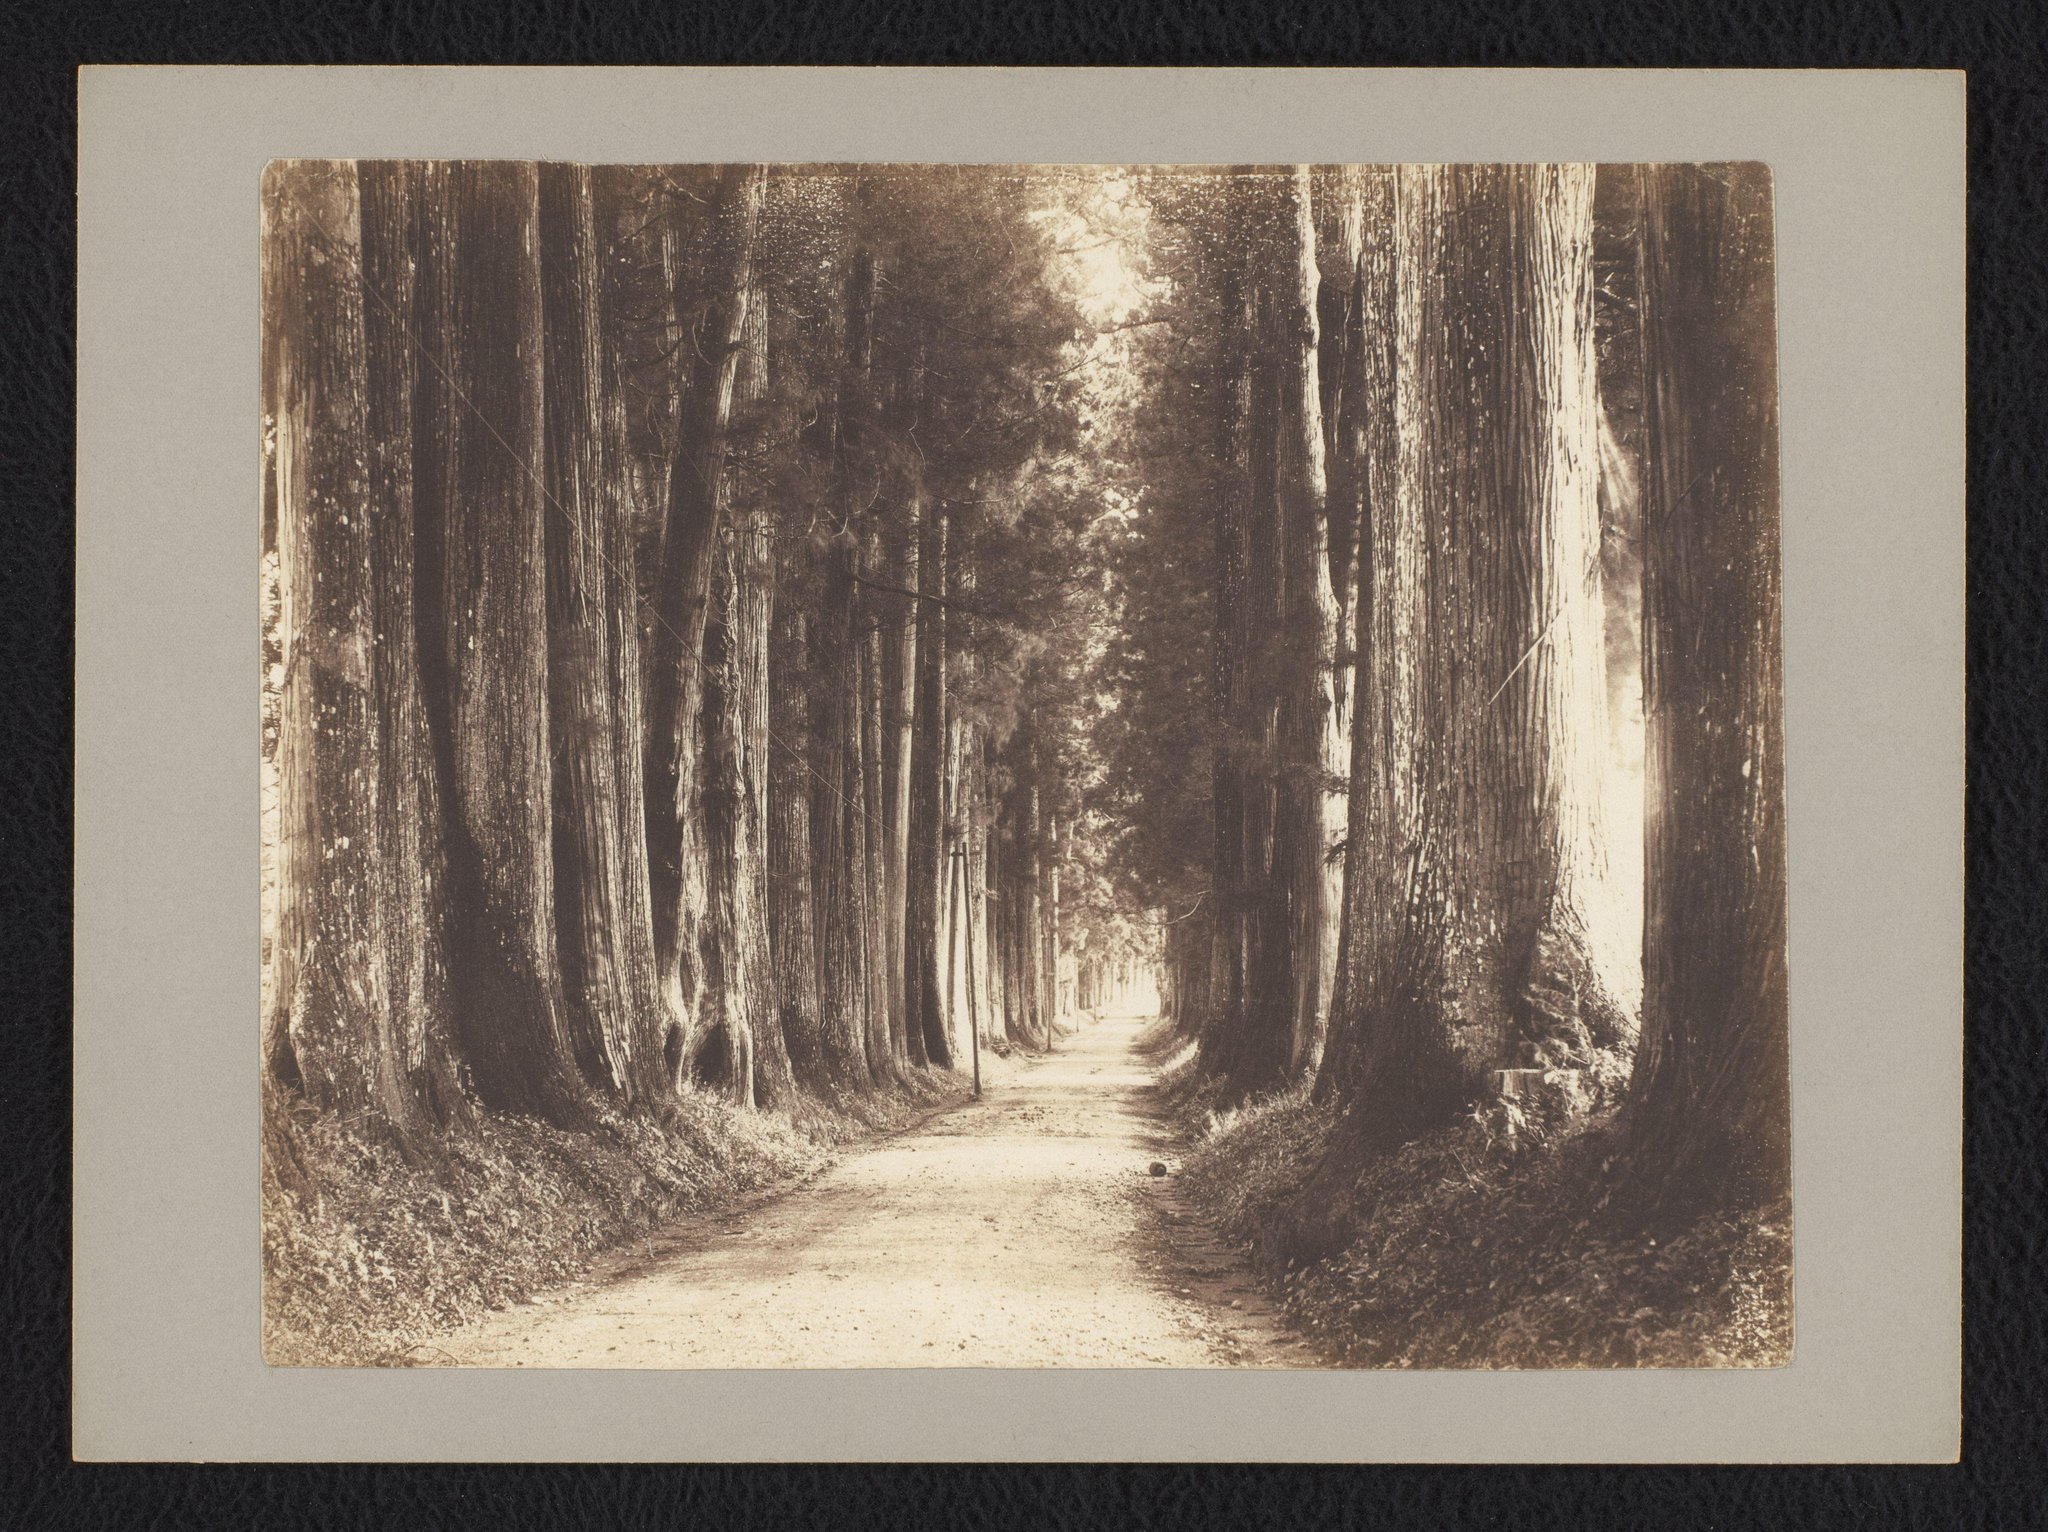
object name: photograph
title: Cryptomeria-laan, Nikko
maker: Anonymous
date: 1895-1915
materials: cardboard, photographic support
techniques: salted paper print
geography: nikko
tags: nikko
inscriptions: annotation: ‘39. Cryptomeria-laan te Nikko.’